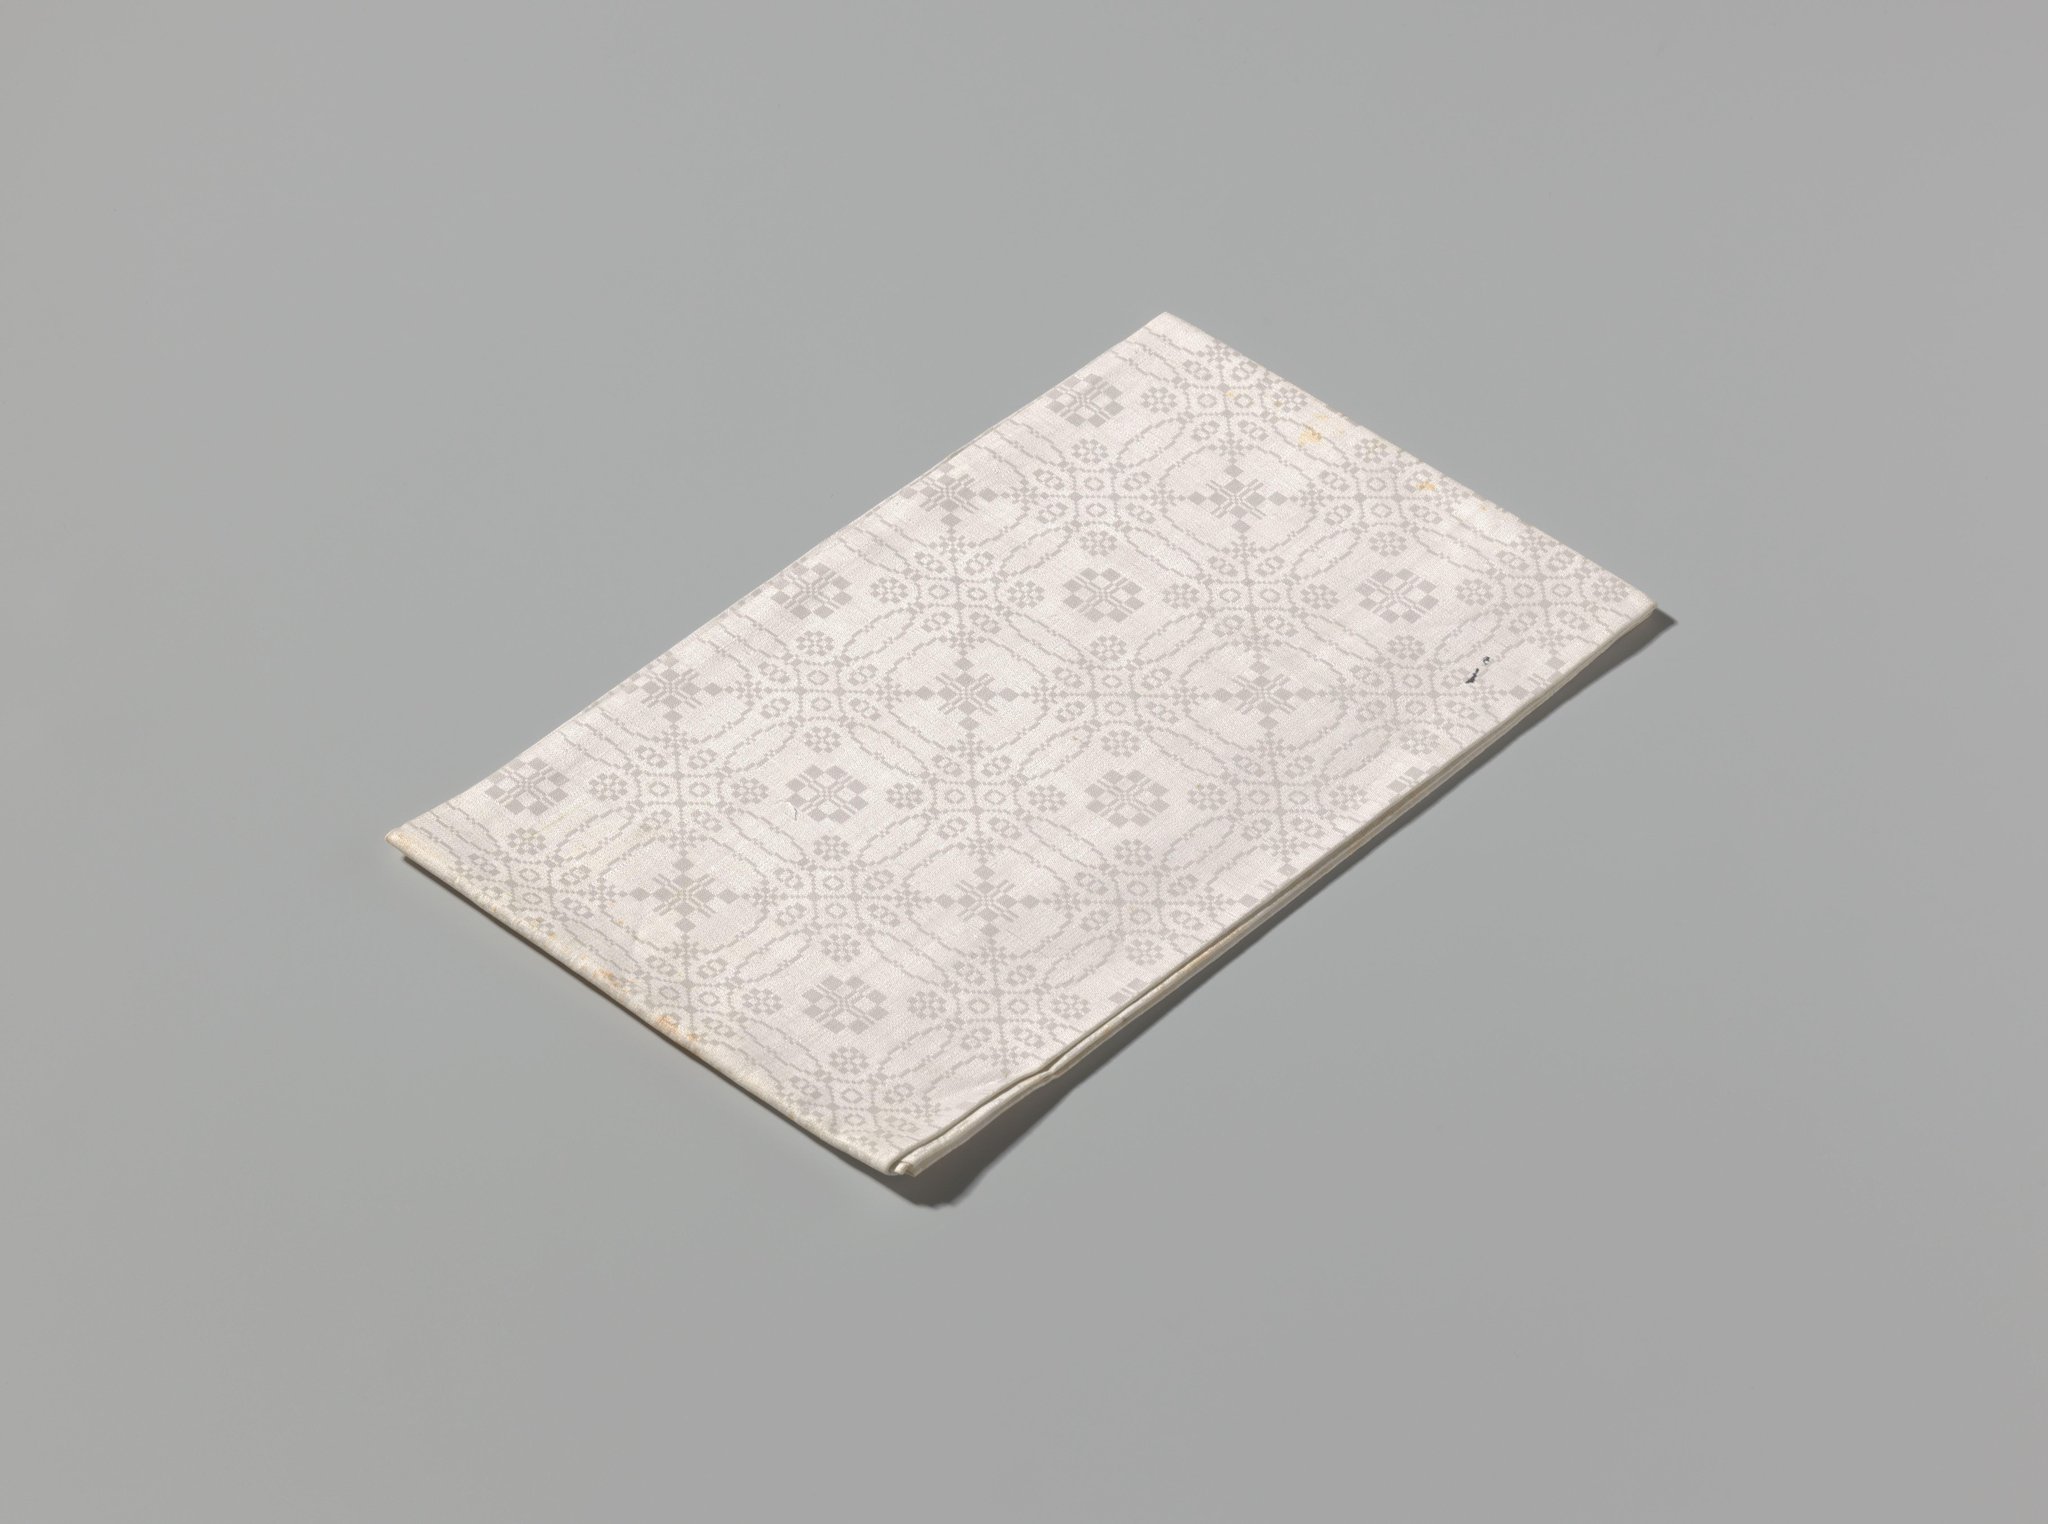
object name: handdwaal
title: Handdwaal van wit linnen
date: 1680-1710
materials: linen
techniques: peeled fabric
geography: northern netherlands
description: Wit linnen handdwaal met pellen patroon. Merk kroon RR.